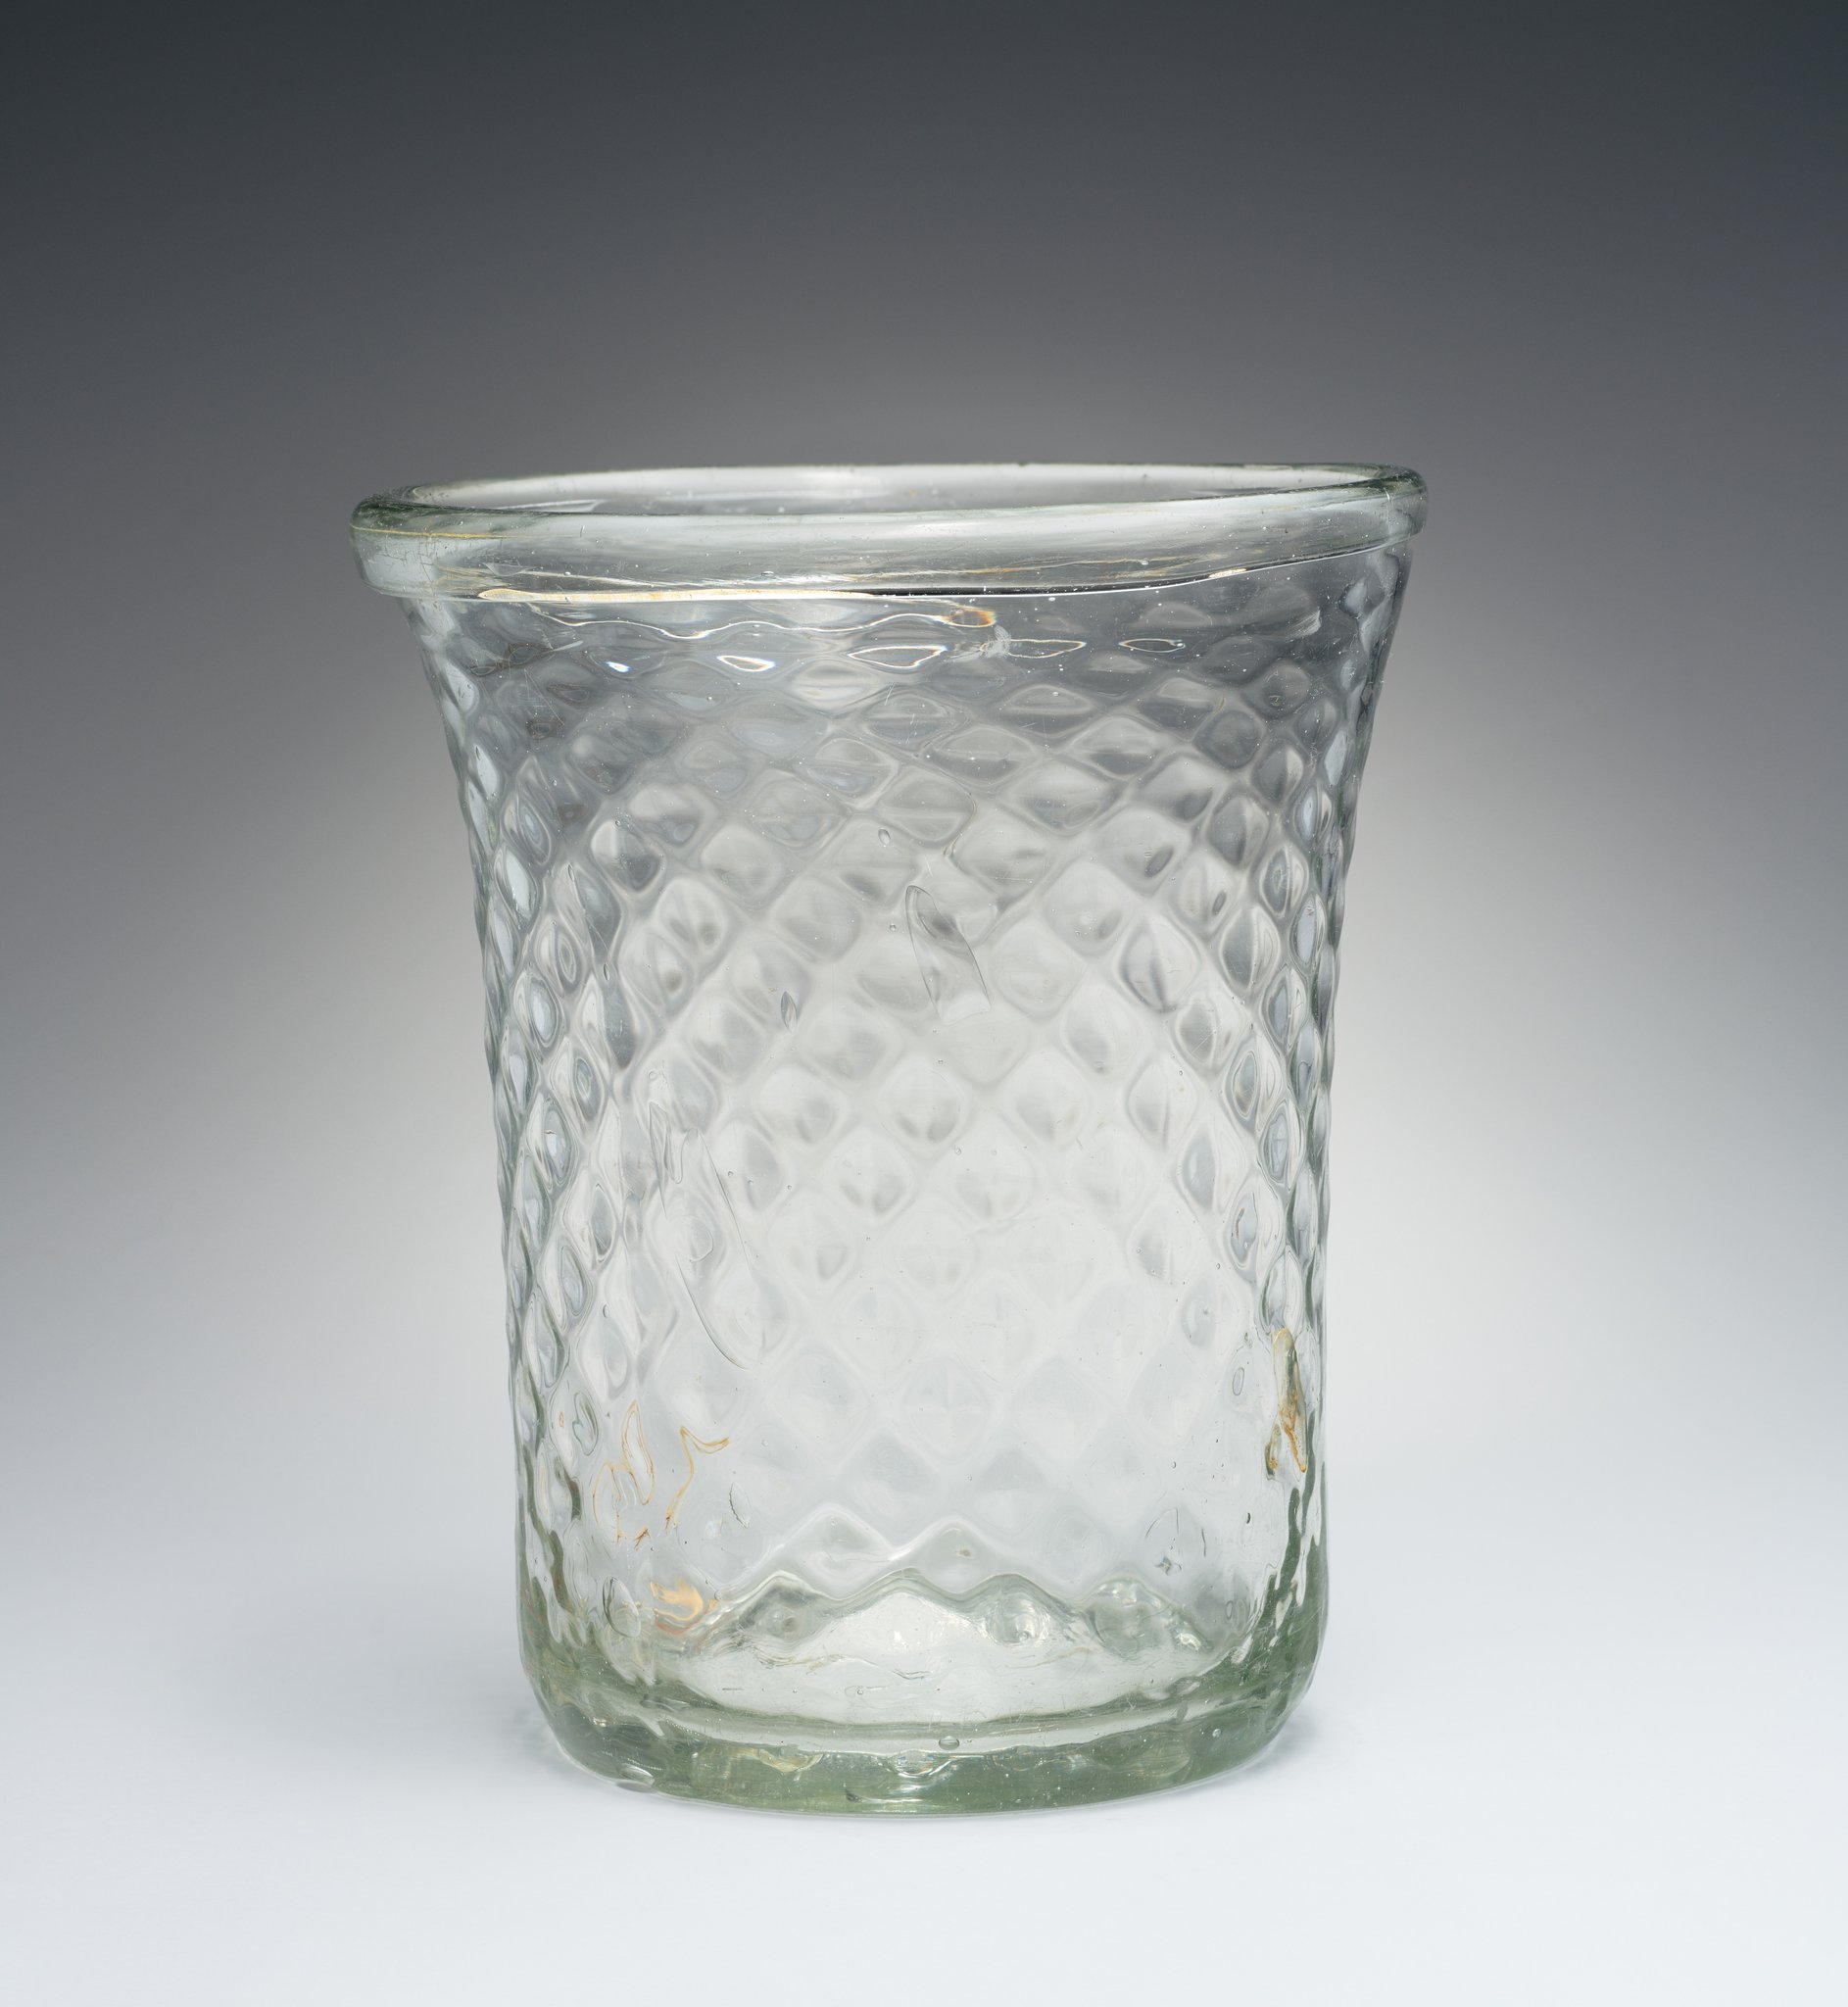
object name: beaker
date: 1601-1700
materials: glass